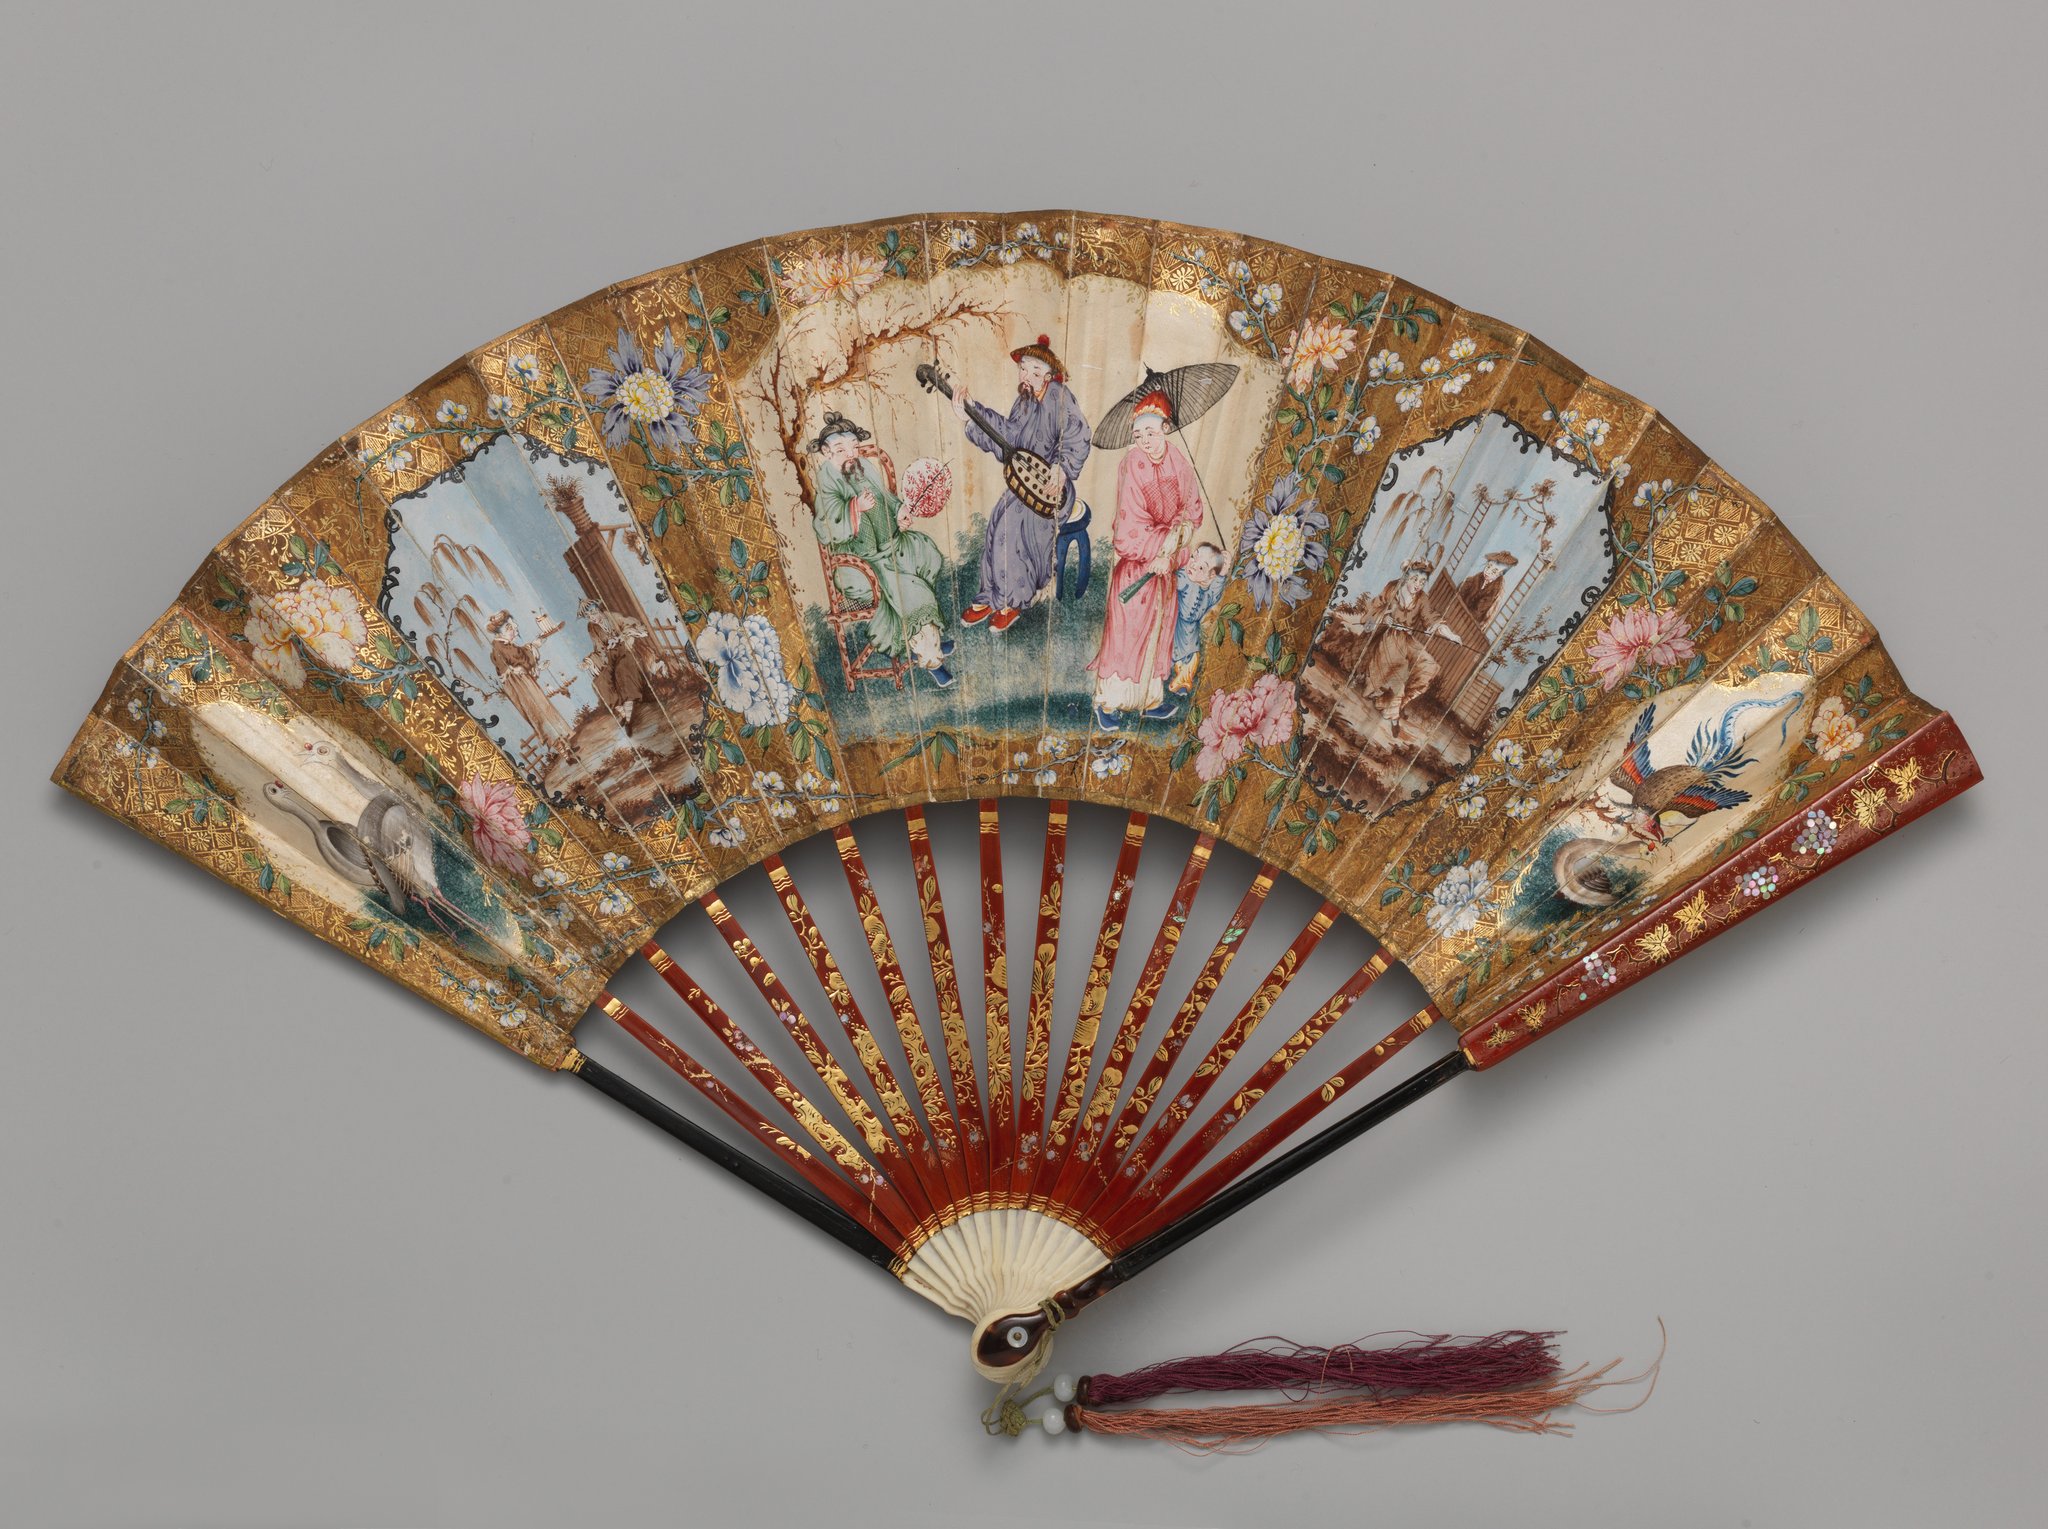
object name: fan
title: Folding Fan with Scene of a Musical Concert, flanked by a Fisherman and Birds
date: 1734-1766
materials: ivory, paper, shell, wood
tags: musical instruments,birds,boys,men,women